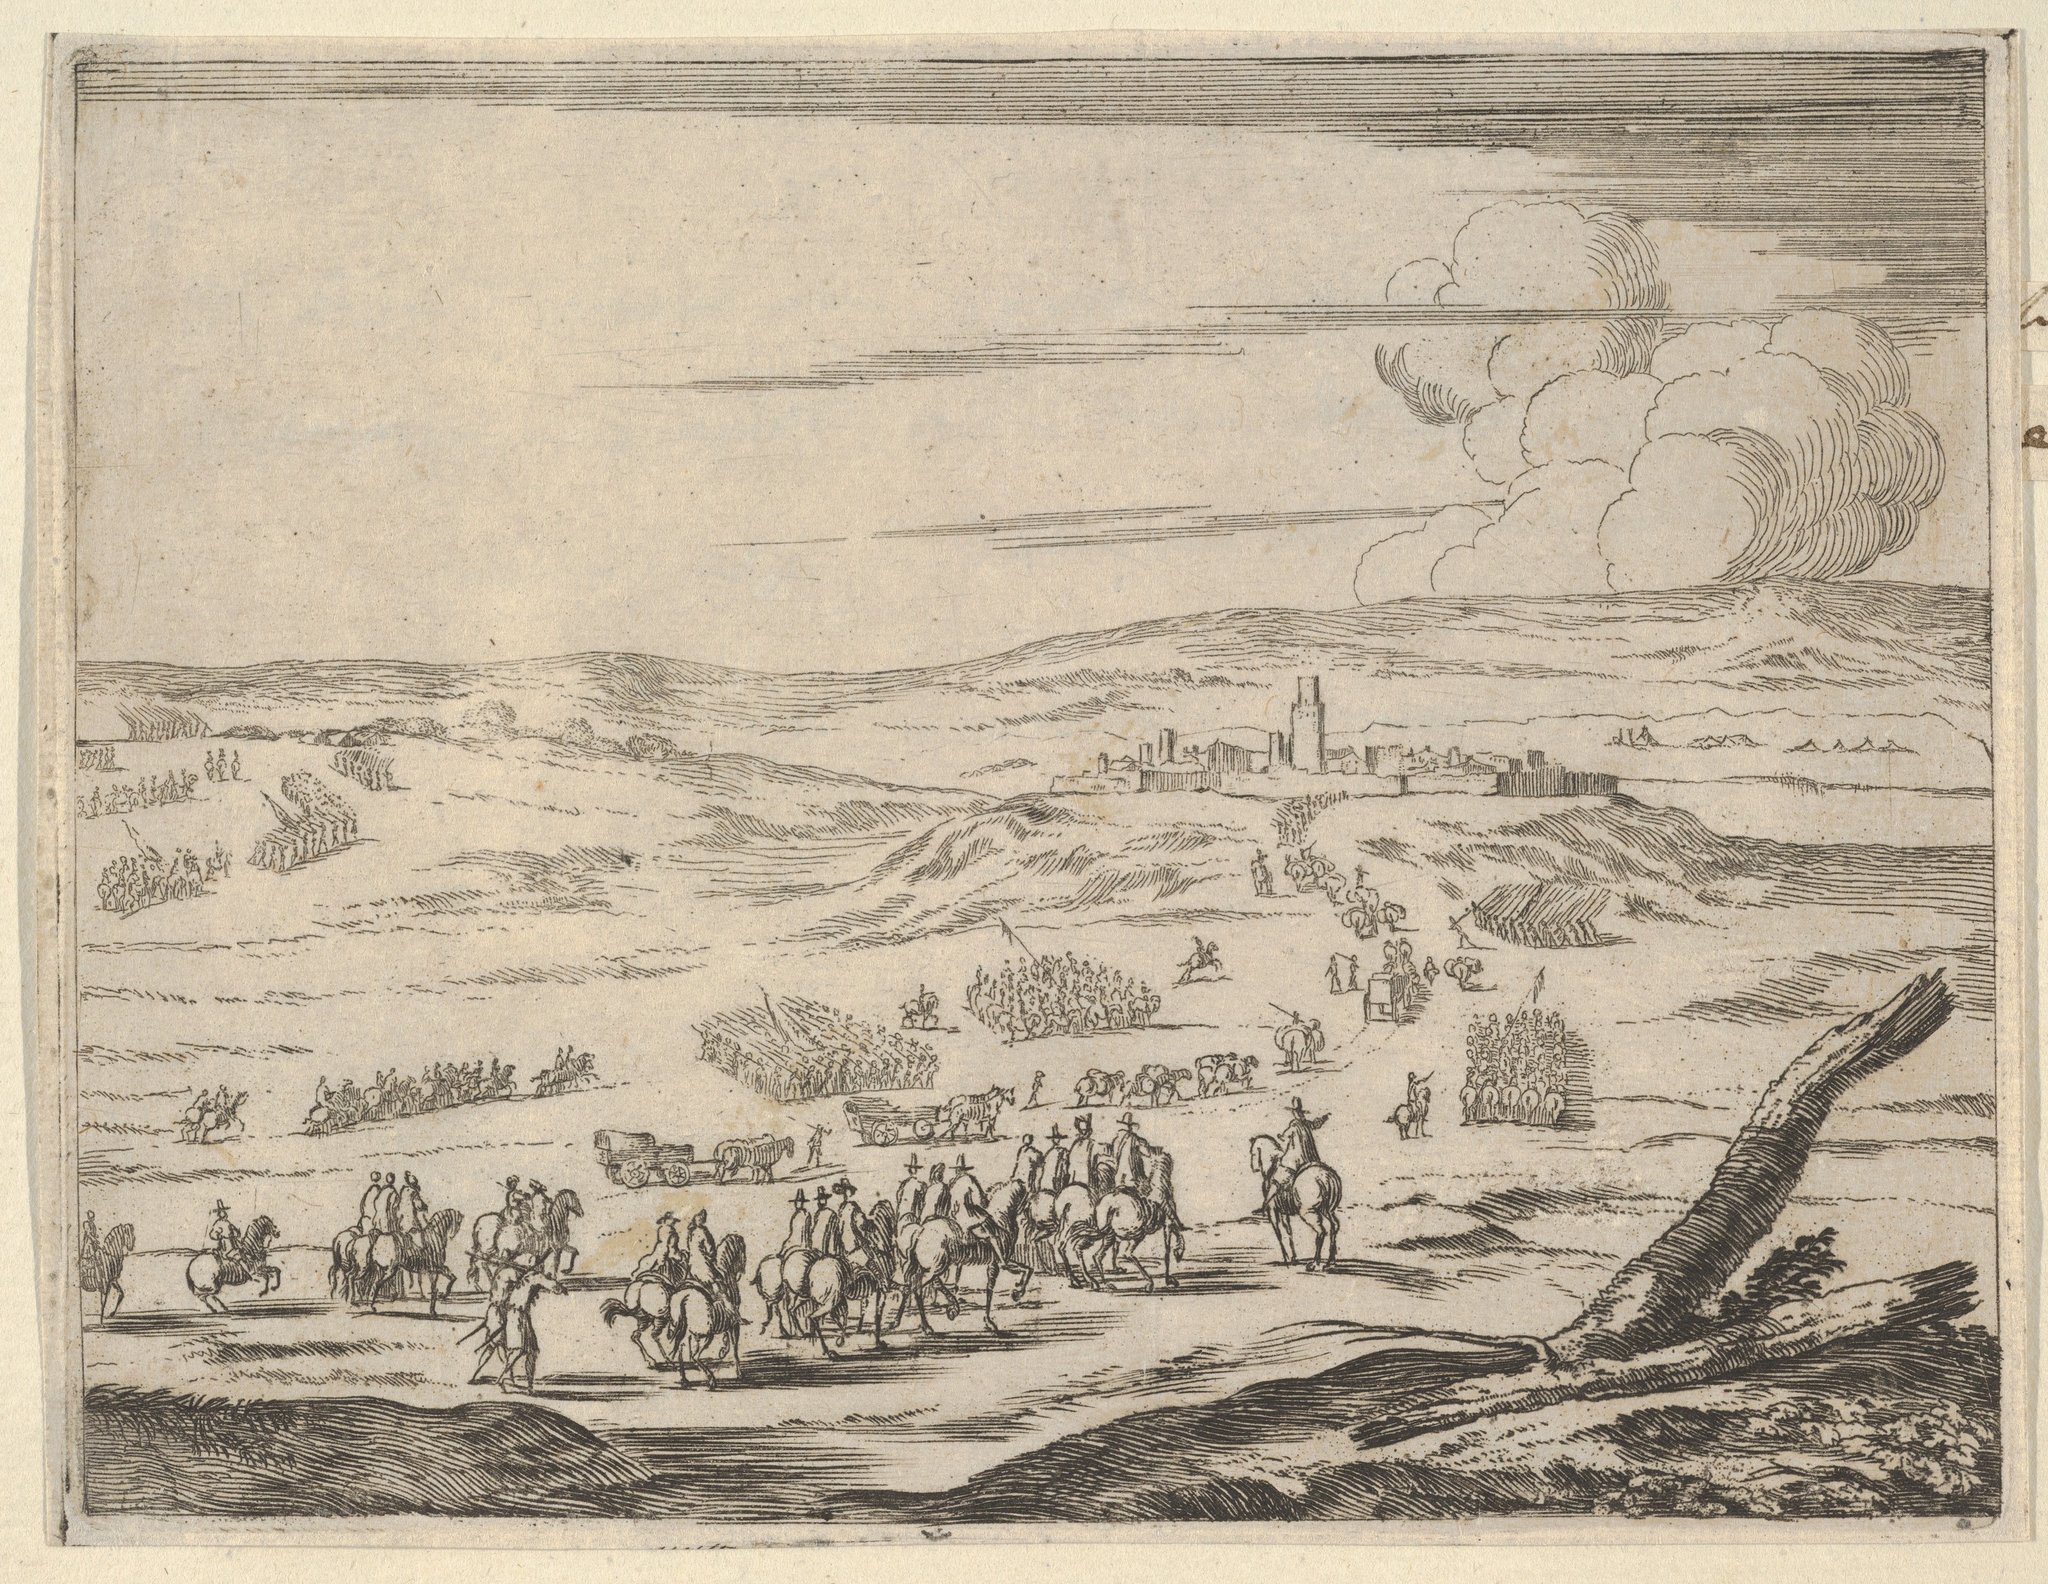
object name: print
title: Despite the Corageous Opposition of the Germans and the Spanish, Francesco I d'Este, at the Head of his Armies, Arrives at the Piazza di Valeneza, from L'Idea di un Principe ed Eroe Cristiano in Francesco I d'Este, di Modena e Reggio Duca VIII [...]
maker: bartolomeo fenice (fénis)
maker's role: artist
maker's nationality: italian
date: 1659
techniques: etching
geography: italy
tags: soldiers,men,horses